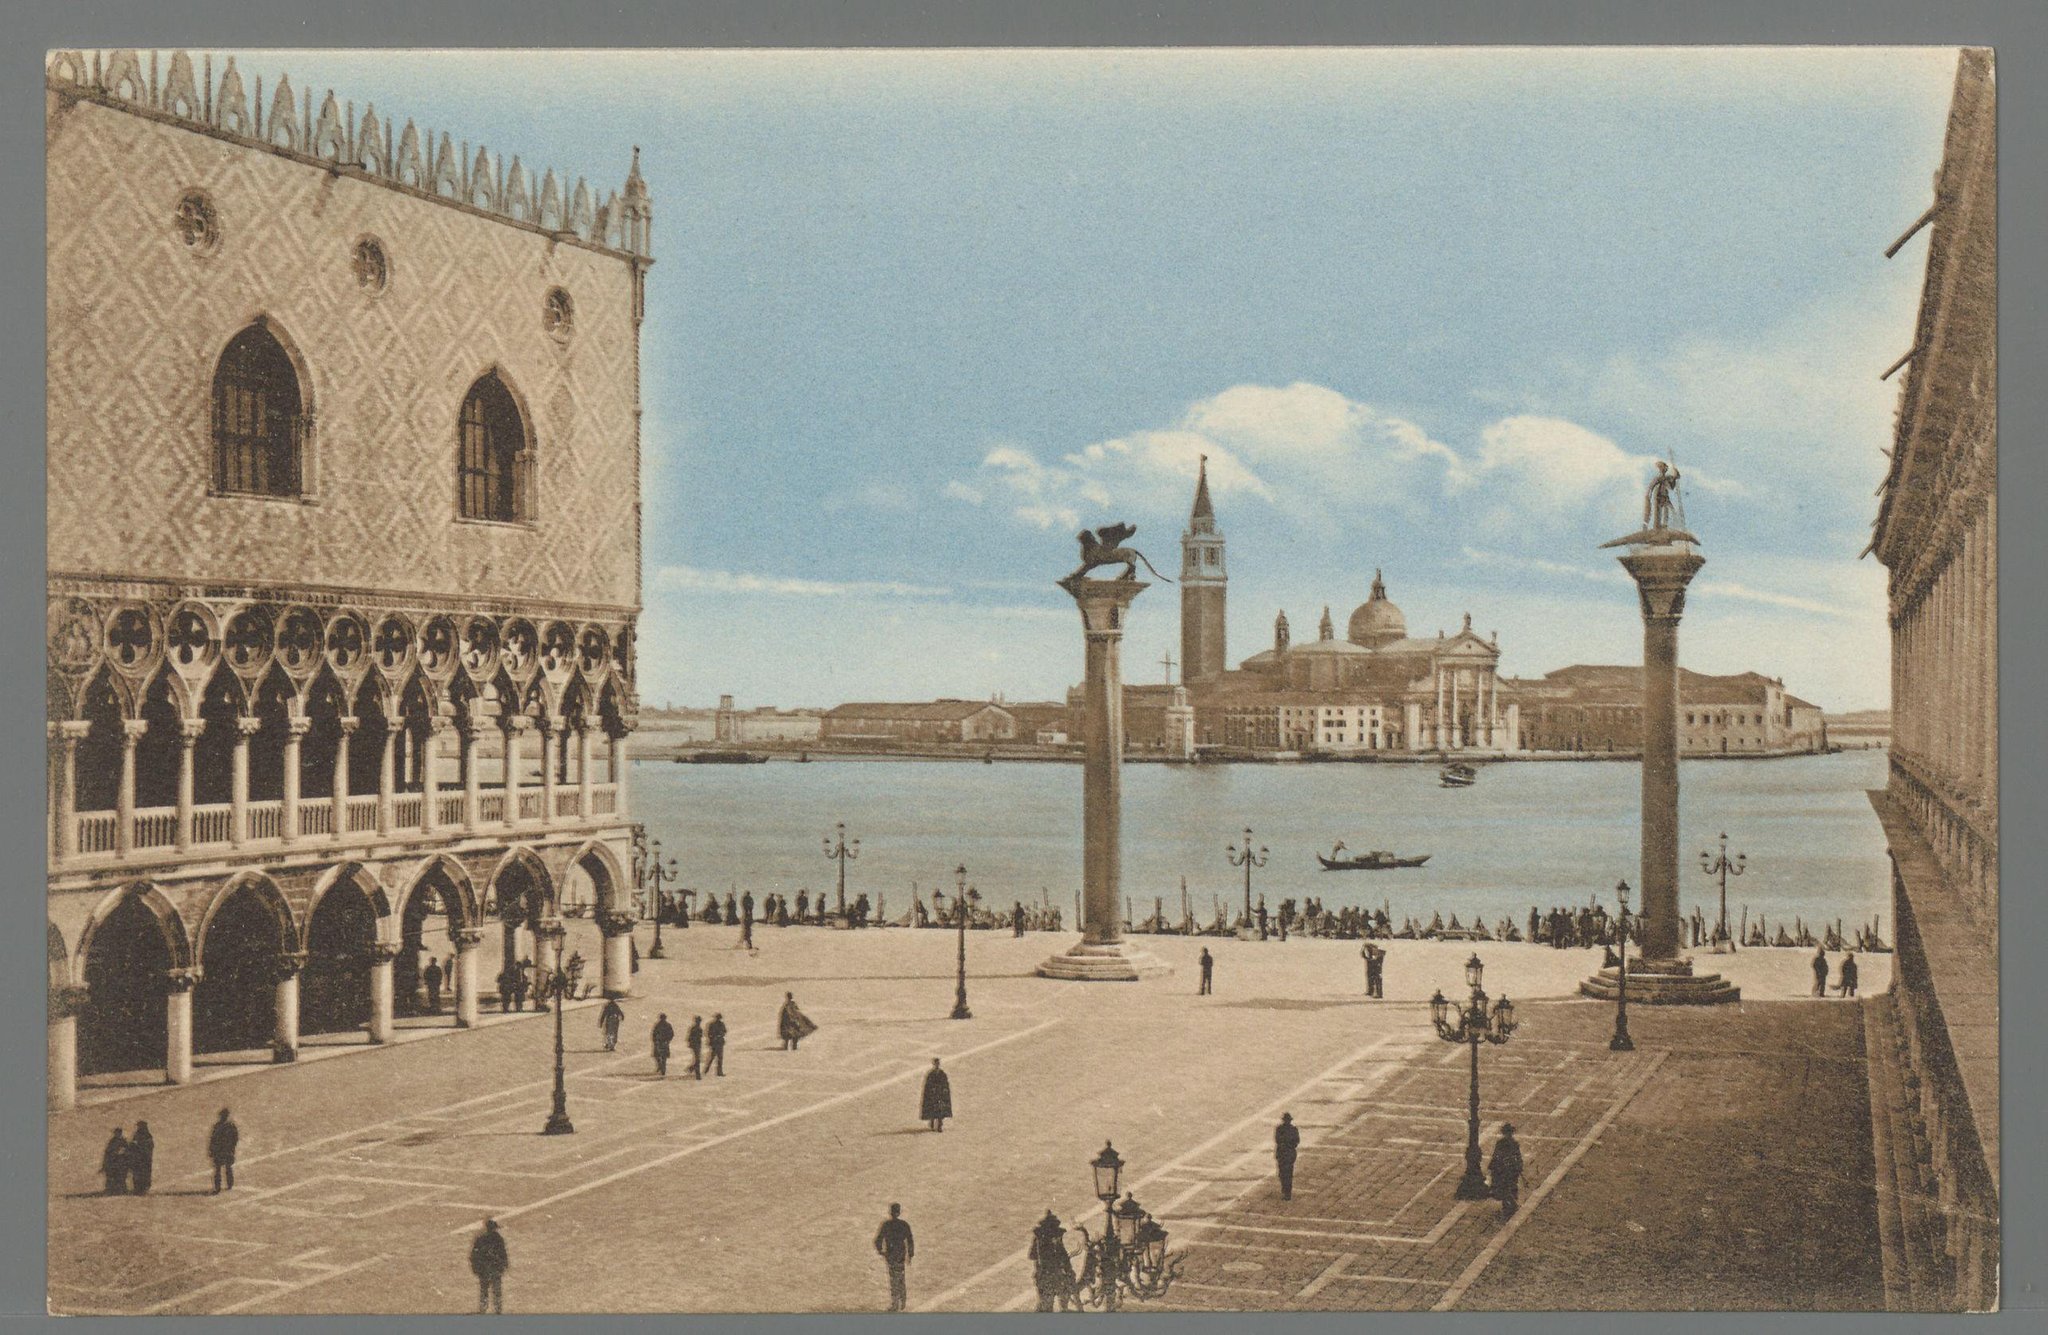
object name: ansichtkaart, prentbriefkaart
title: Venezia. Piazzetta, le due colonne e l'isola di S. Giorgio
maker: Anonymous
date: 1906-1920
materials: cardboard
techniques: photograph, lithograph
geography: venice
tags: island, palace, square, place, circus, etc. (+ city(-scape) with figures, staffage)